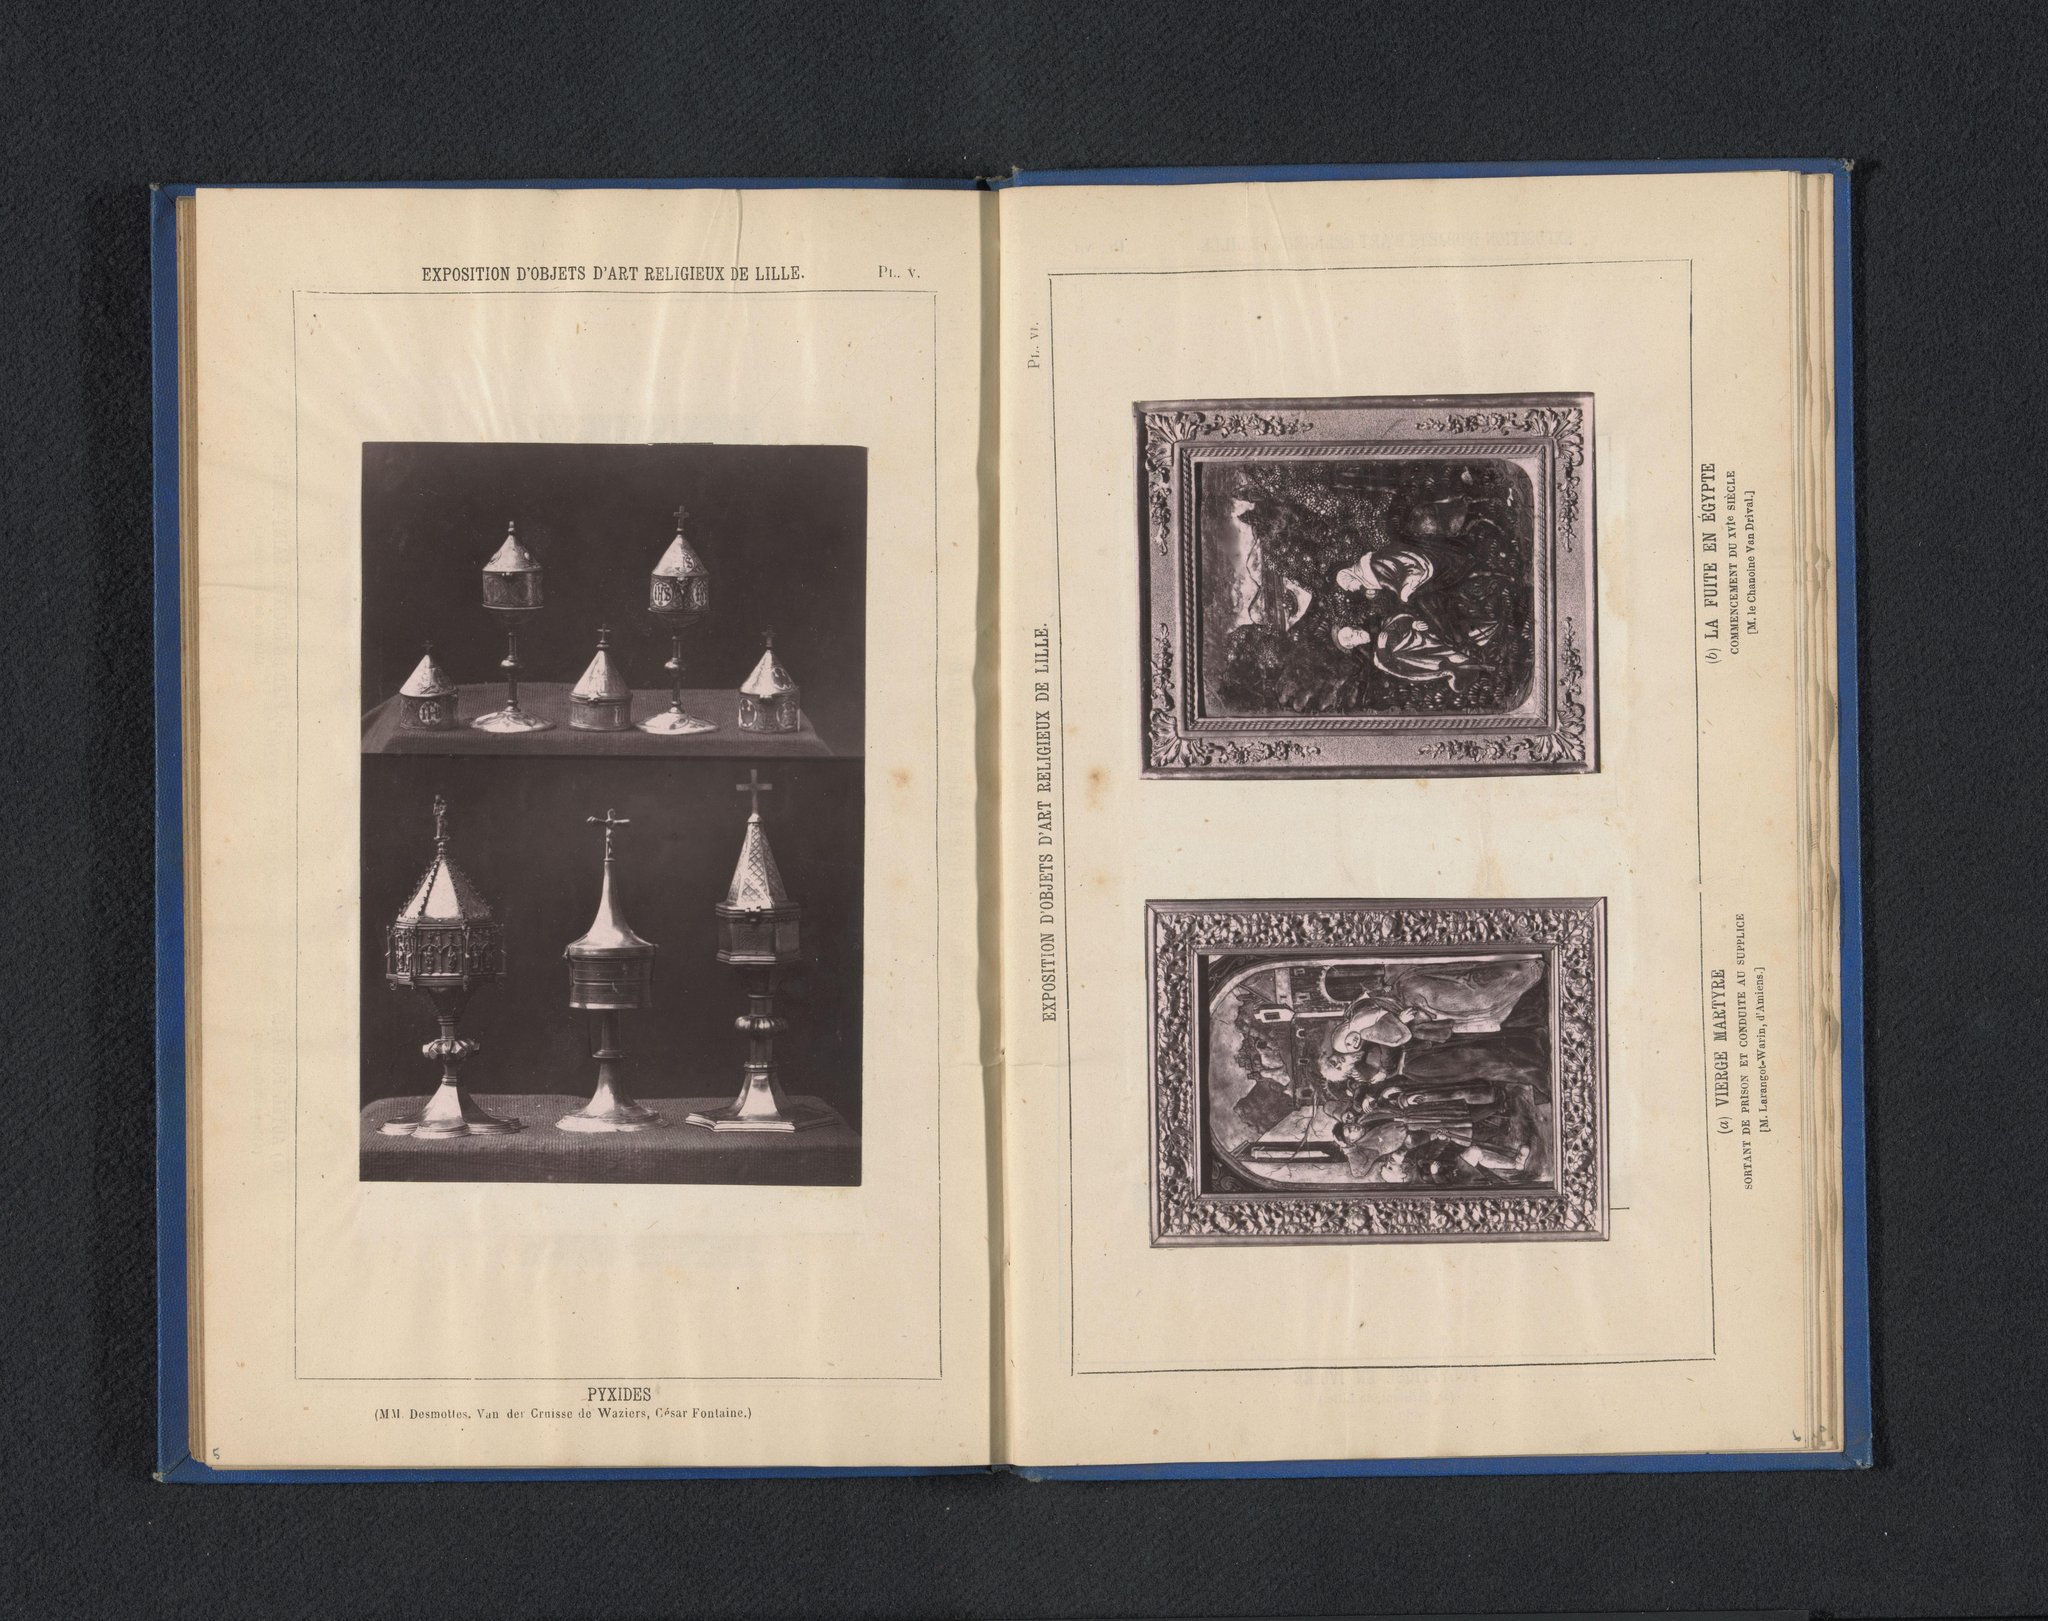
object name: page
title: Reproductie van twee ontwerpen van Maria en de vlucht naar Egypte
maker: Anonymous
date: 1871-1876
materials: cardboard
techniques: woodburytype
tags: mary (without the christ-child), the massacre of the innocents and the flight into egypt (matthew 2:13-23)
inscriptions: inscription: ‘Sortant de prison et conduite au supplice (...)’, inscription: ‘Pl. VI.’, inscription: ‘Exposition d'objets d'art religieux de Lille’